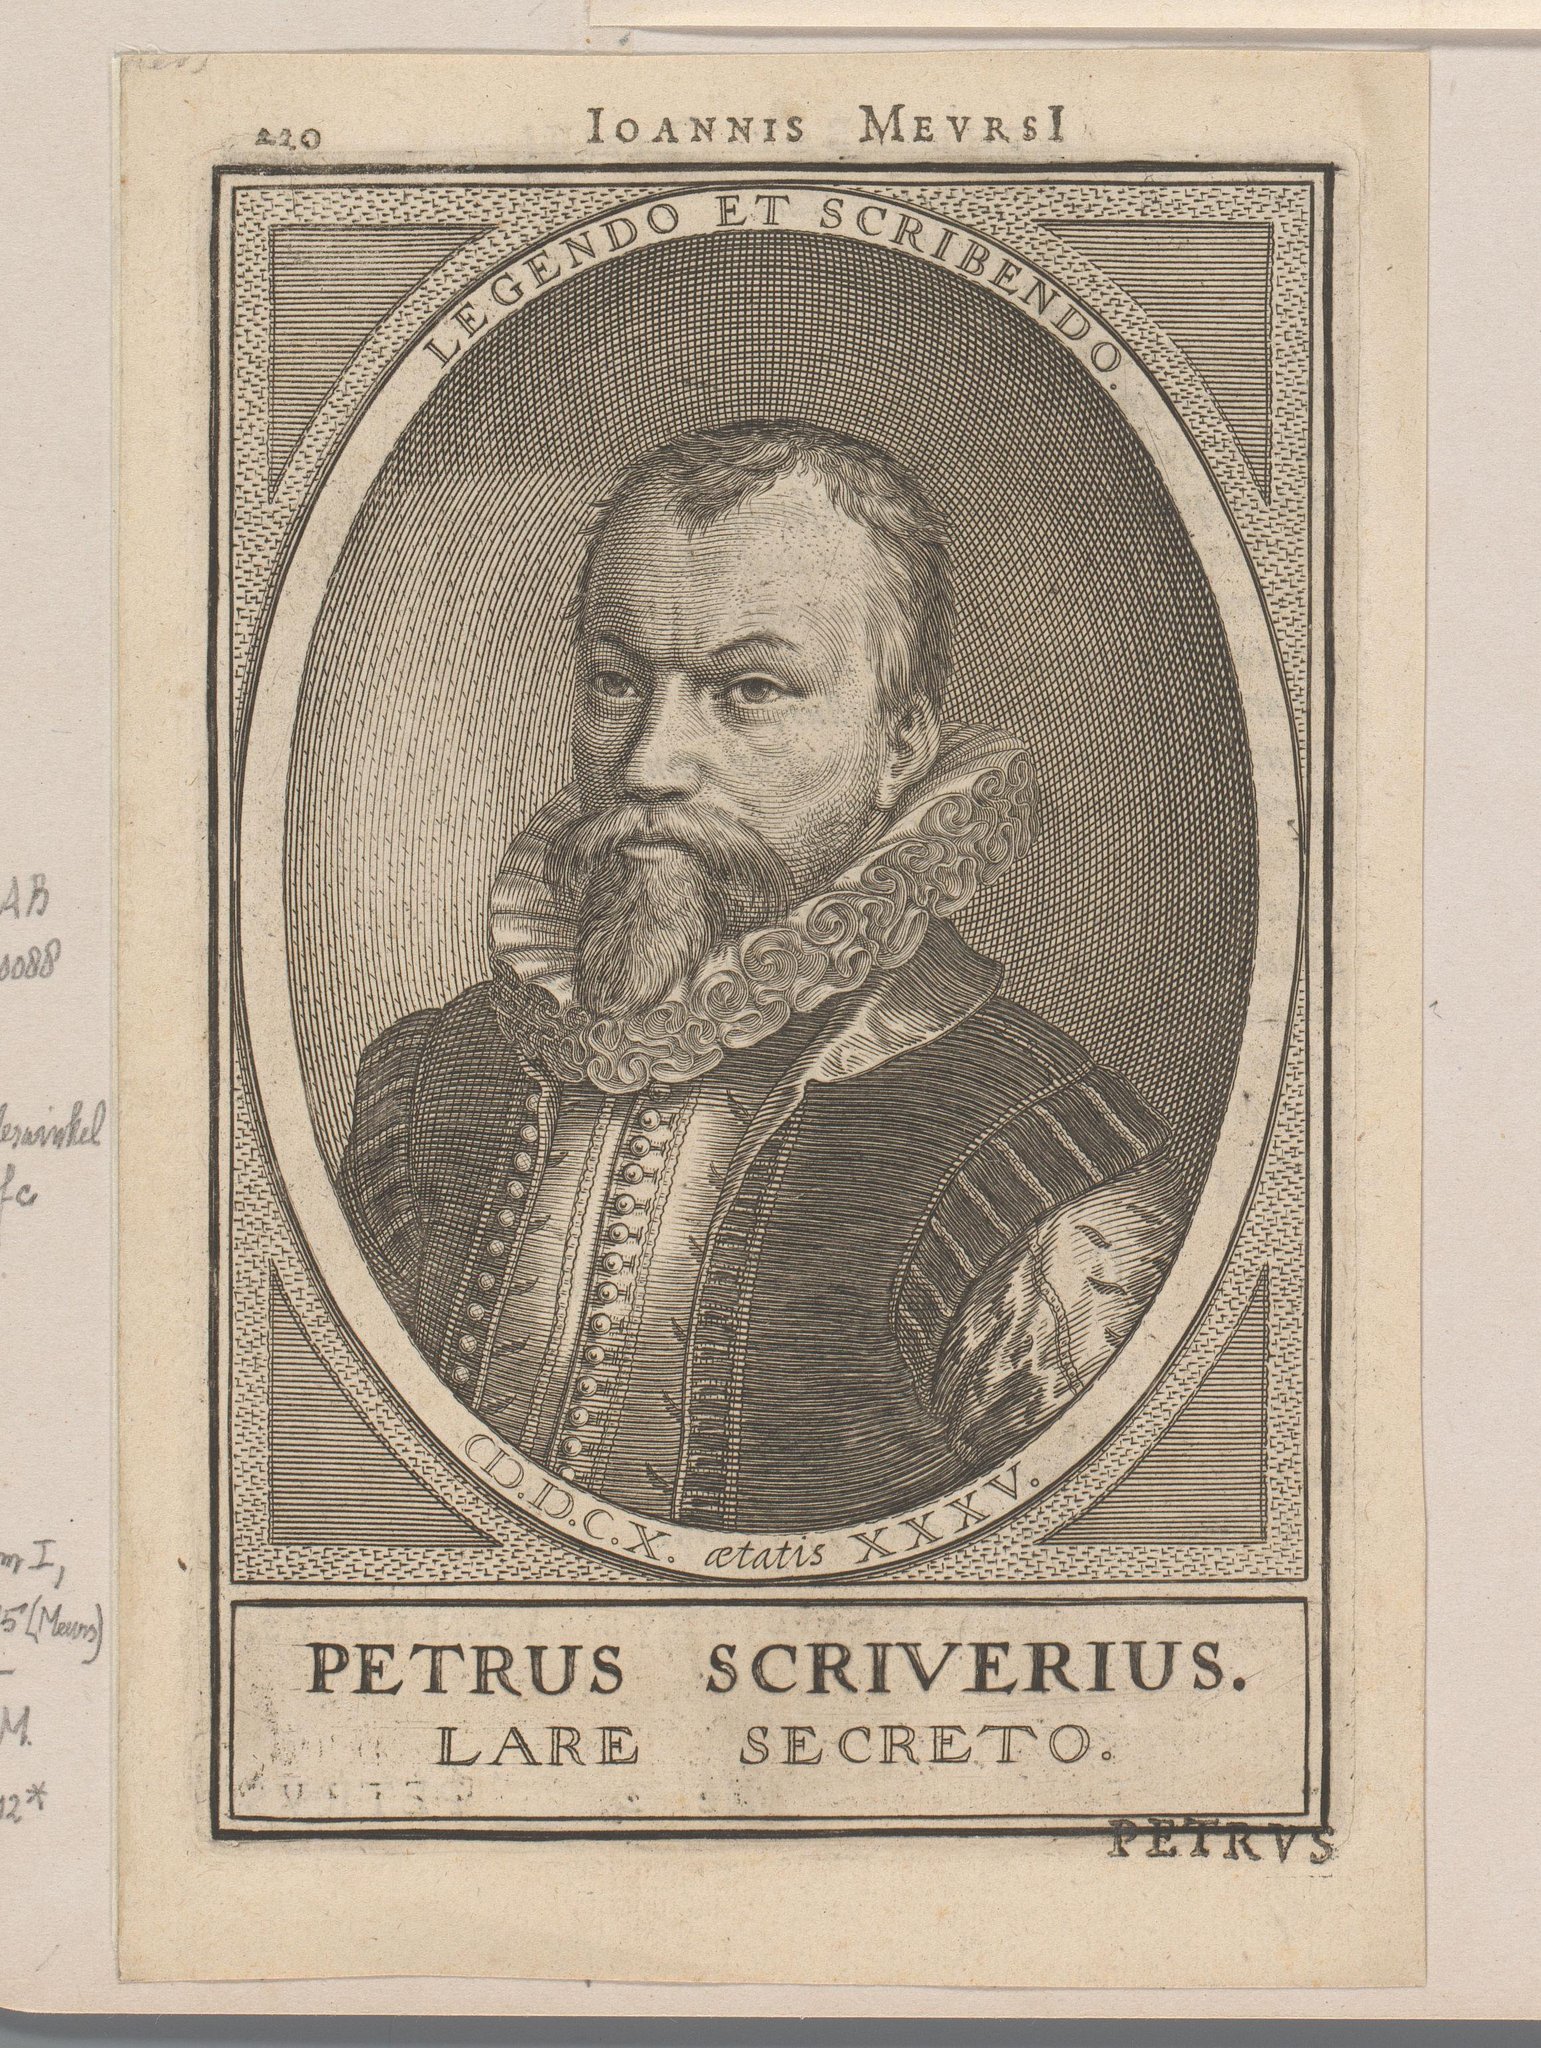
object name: print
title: Portret van Petrus Scriverius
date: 1625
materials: paper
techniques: engraving, etching, letterpress printing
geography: leiden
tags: petrus scriverius, philology (+ portrait of scholar, scientist), historical persons, portrait of a writer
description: Prent uit: Meurs, Johannes. Athenae Batavae, sive de urbe Leidensi atque academia (...). Leiden: Andries Clouck, 1625.